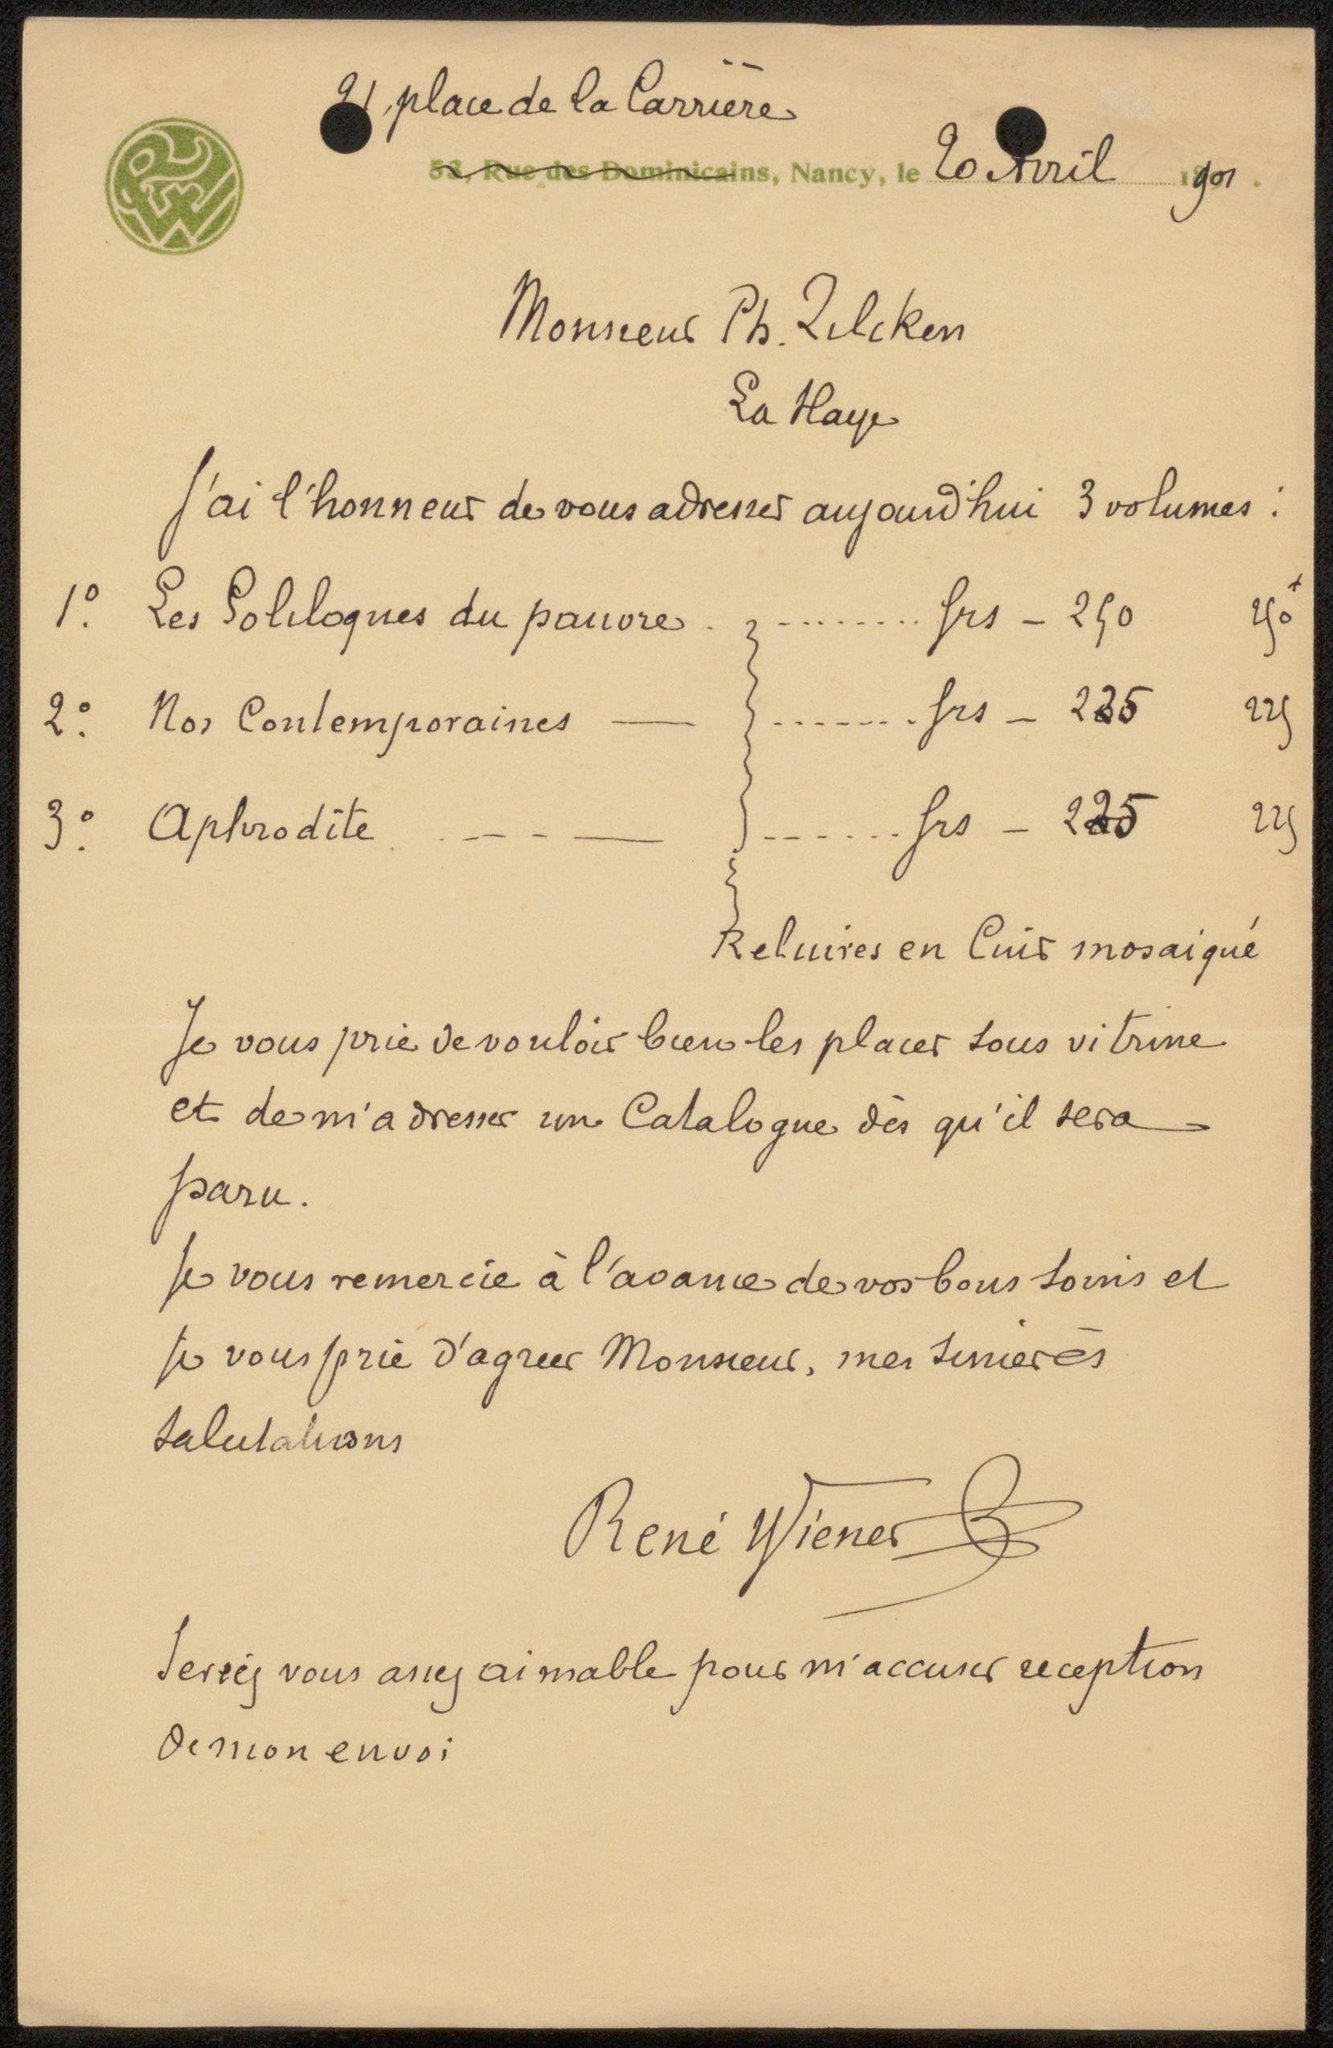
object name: letter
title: Brief aan Philip Zilcken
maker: rené wiener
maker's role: boekbinder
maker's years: 1855-1939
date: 1901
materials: ink, paper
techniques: pen, printing, writing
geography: nancy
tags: painter, draughtsman, philip zilcken, money, printed matter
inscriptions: collector's mark: ‘RPK’